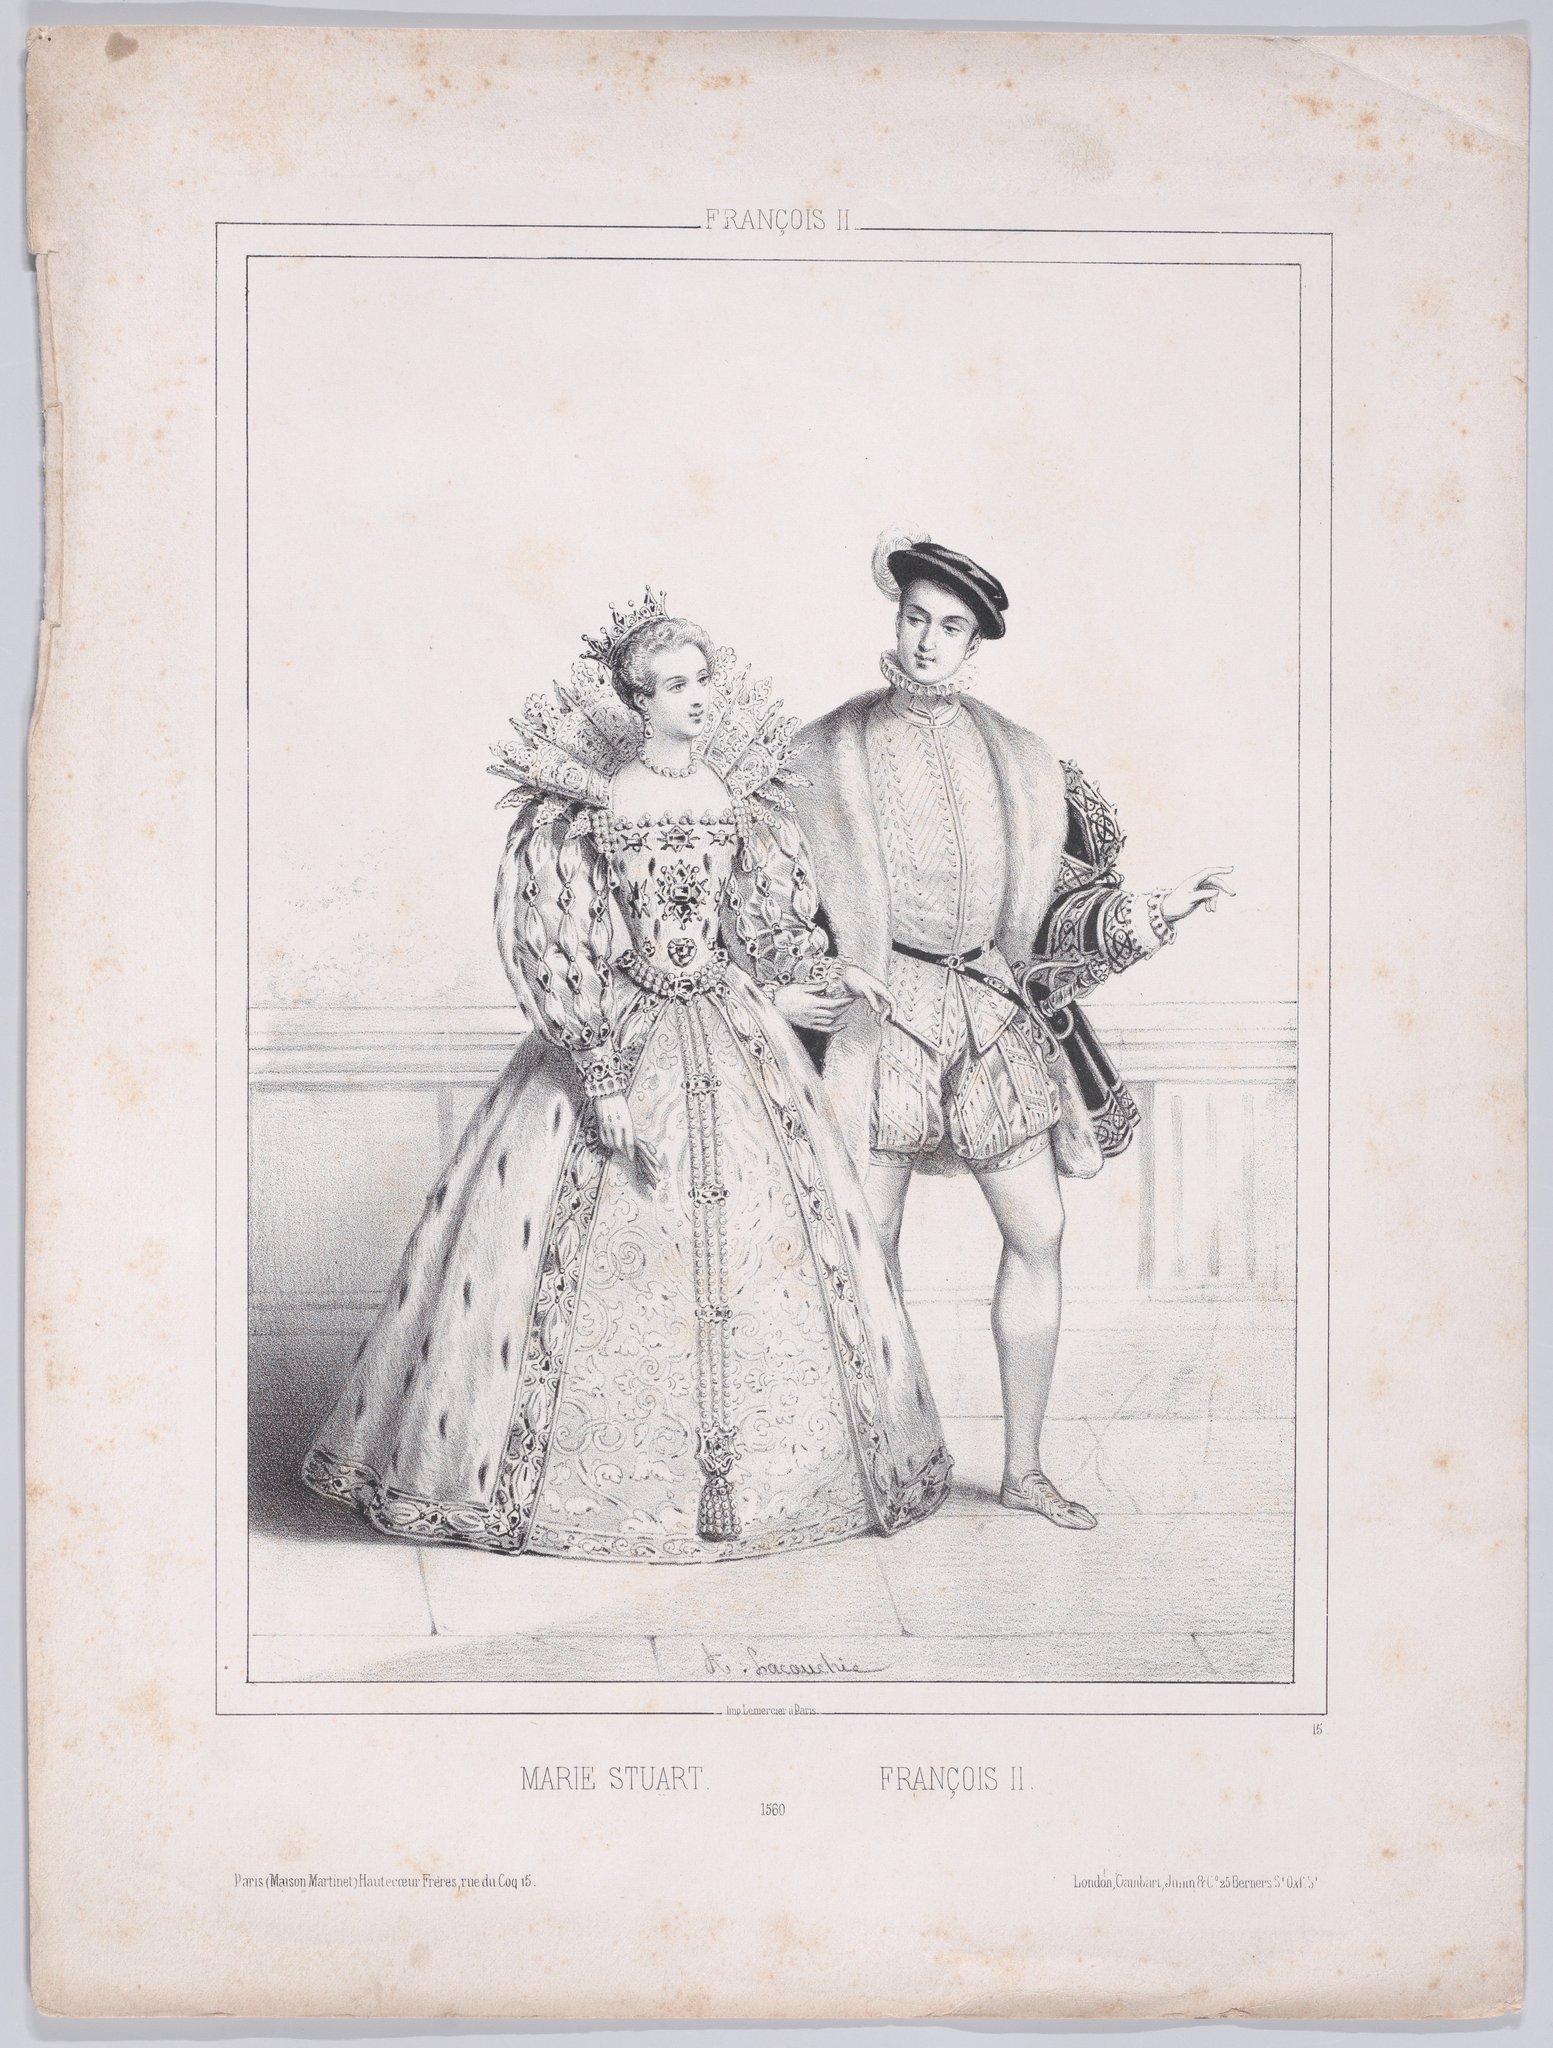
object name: print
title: Mary, Queen of Scots and Francis II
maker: alexandre lacauchie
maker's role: artist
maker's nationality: french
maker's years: 1833-1846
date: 1834-1866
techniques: lithograph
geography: france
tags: queens,men,portraits,women,mary queen of scots